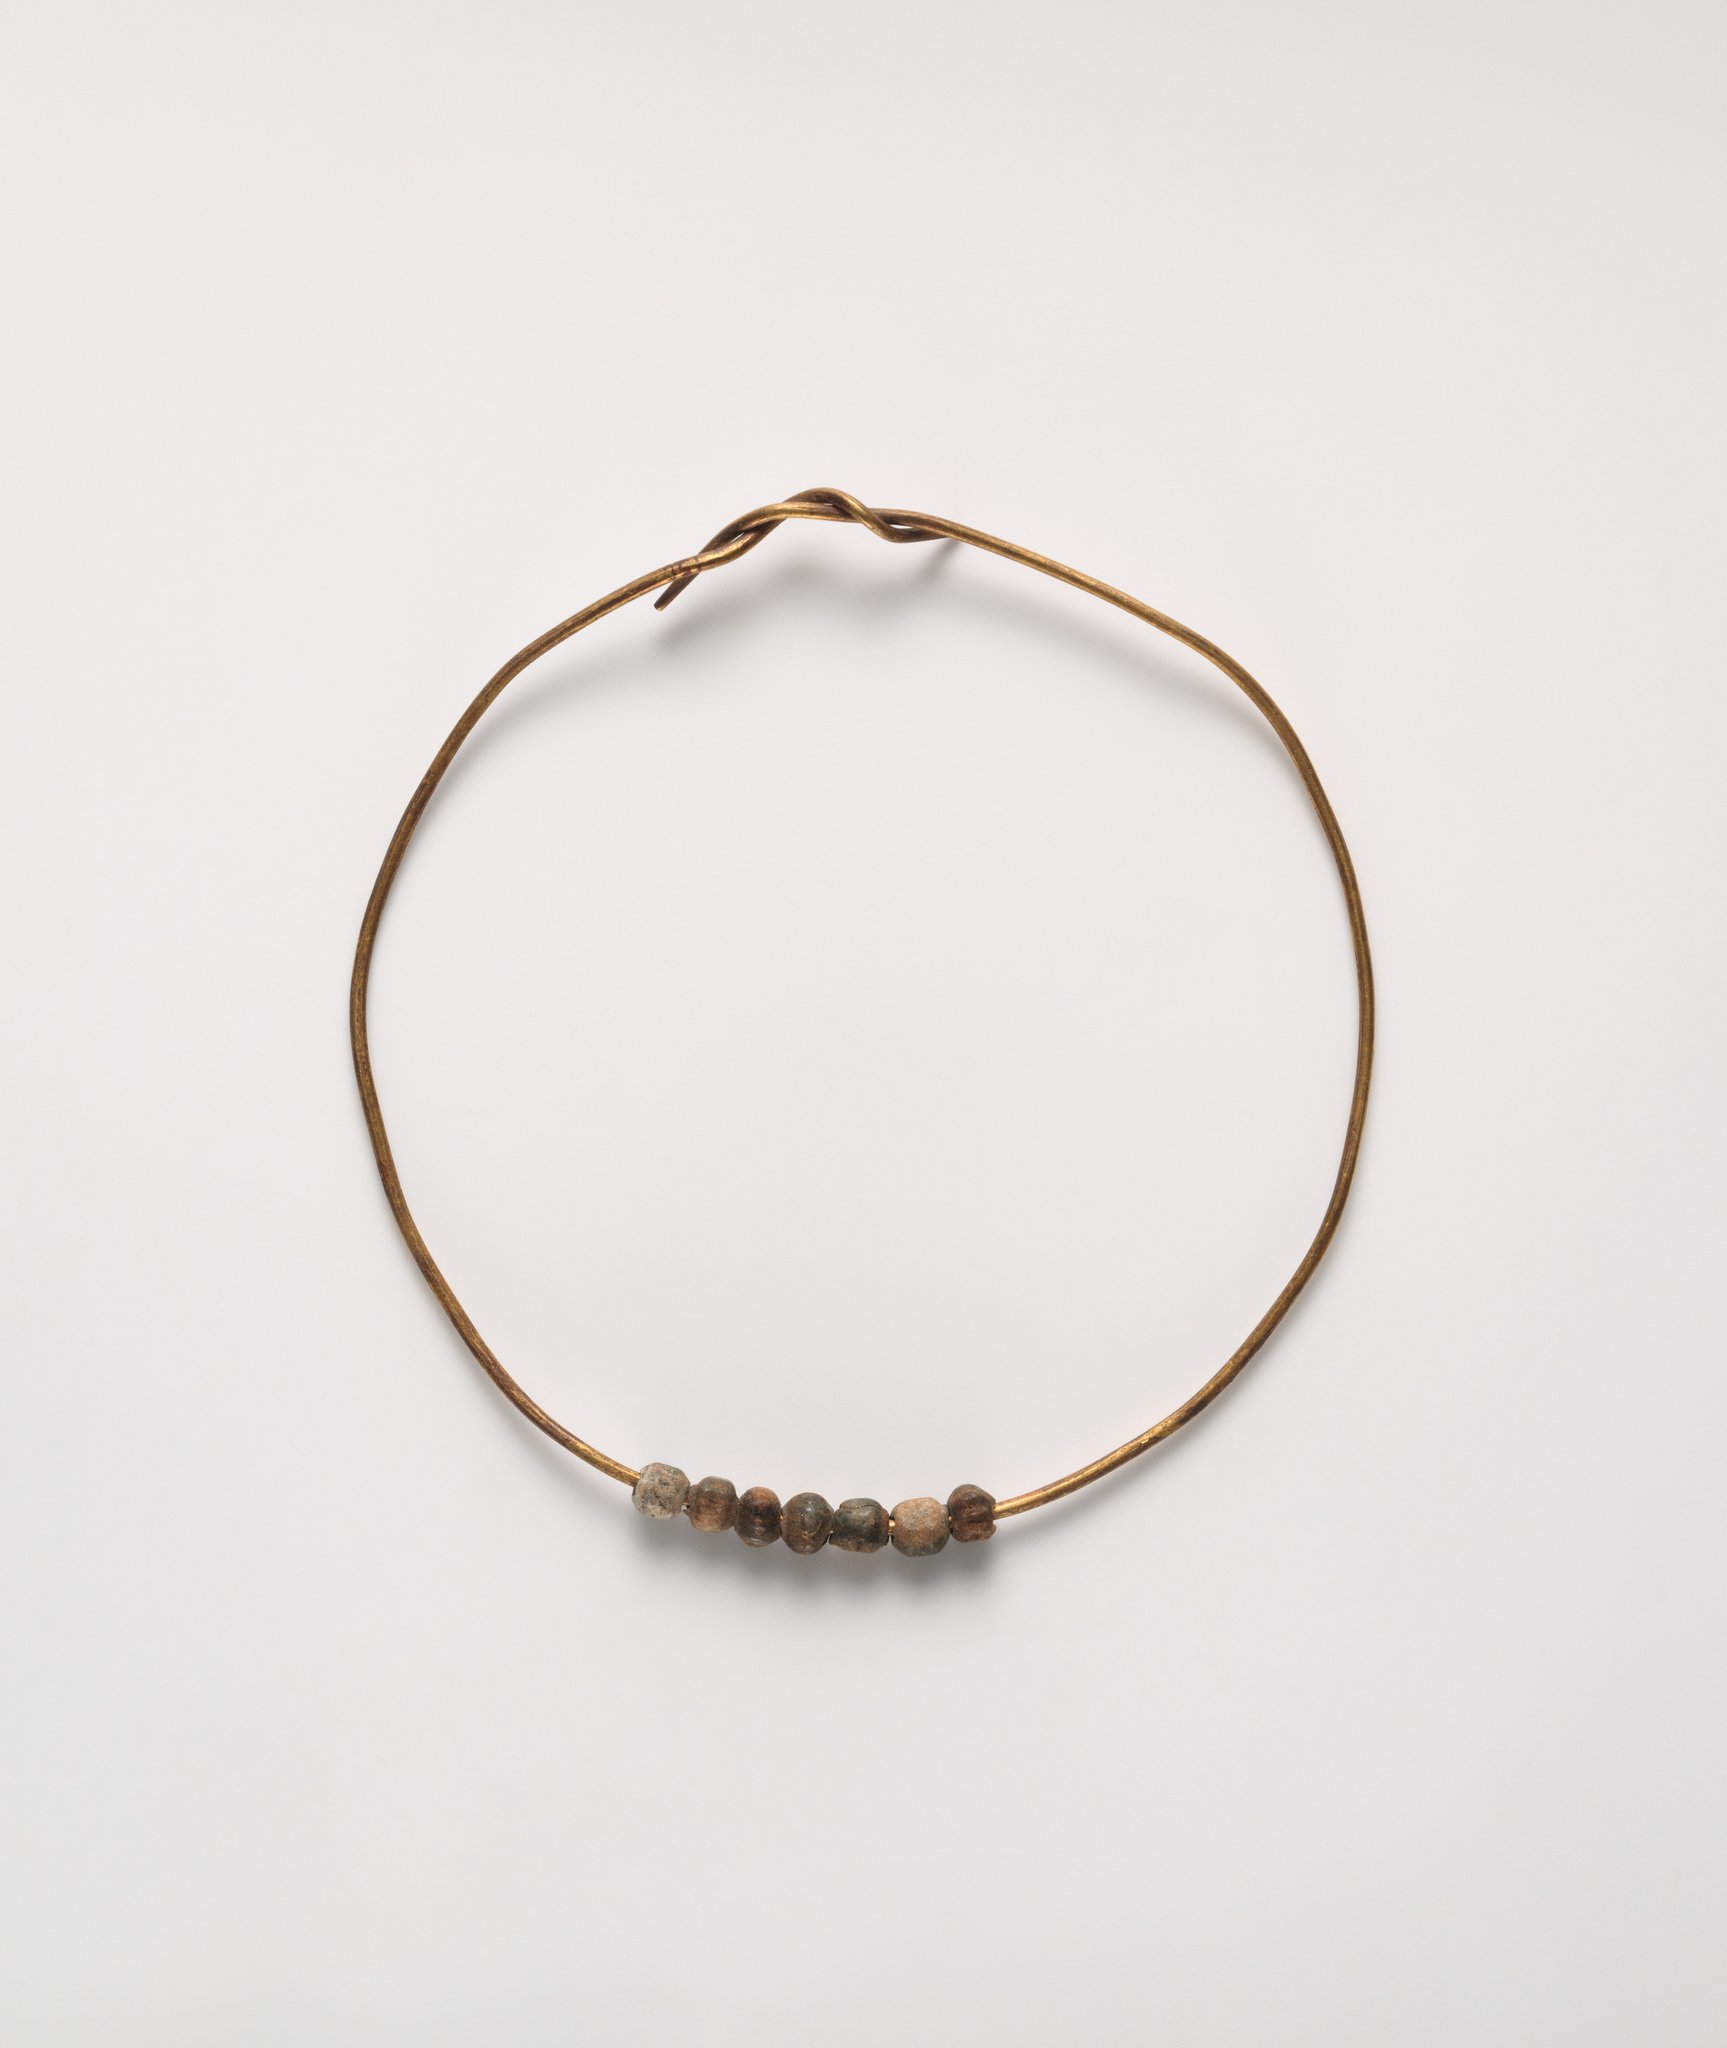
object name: torque, mellon shaped bead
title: Melon Beads on Gold Wire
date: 1479-1425 BCE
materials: faience, gold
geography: egypt